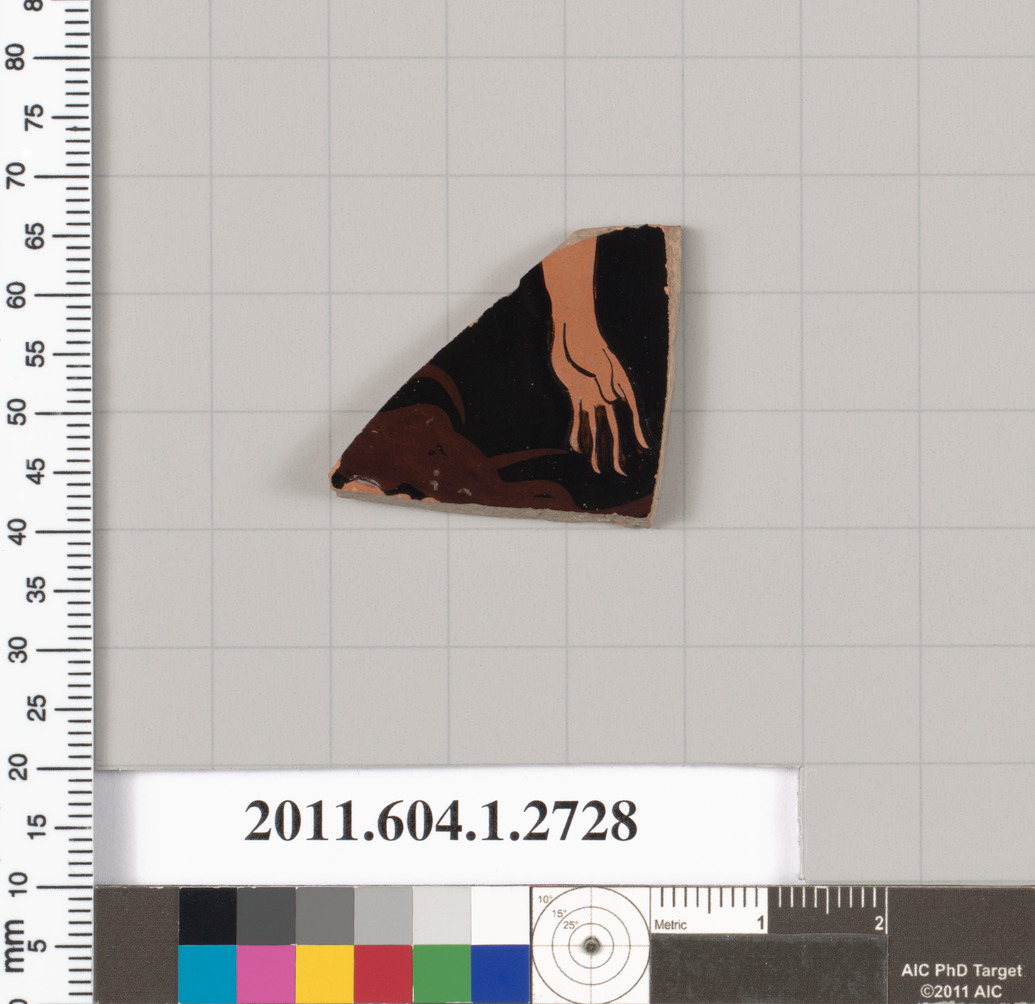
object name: kylix fragment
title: Terracotta fragment of a kylix (drinking cup)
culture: greek, attic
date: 490-480 BCE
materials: terracotta